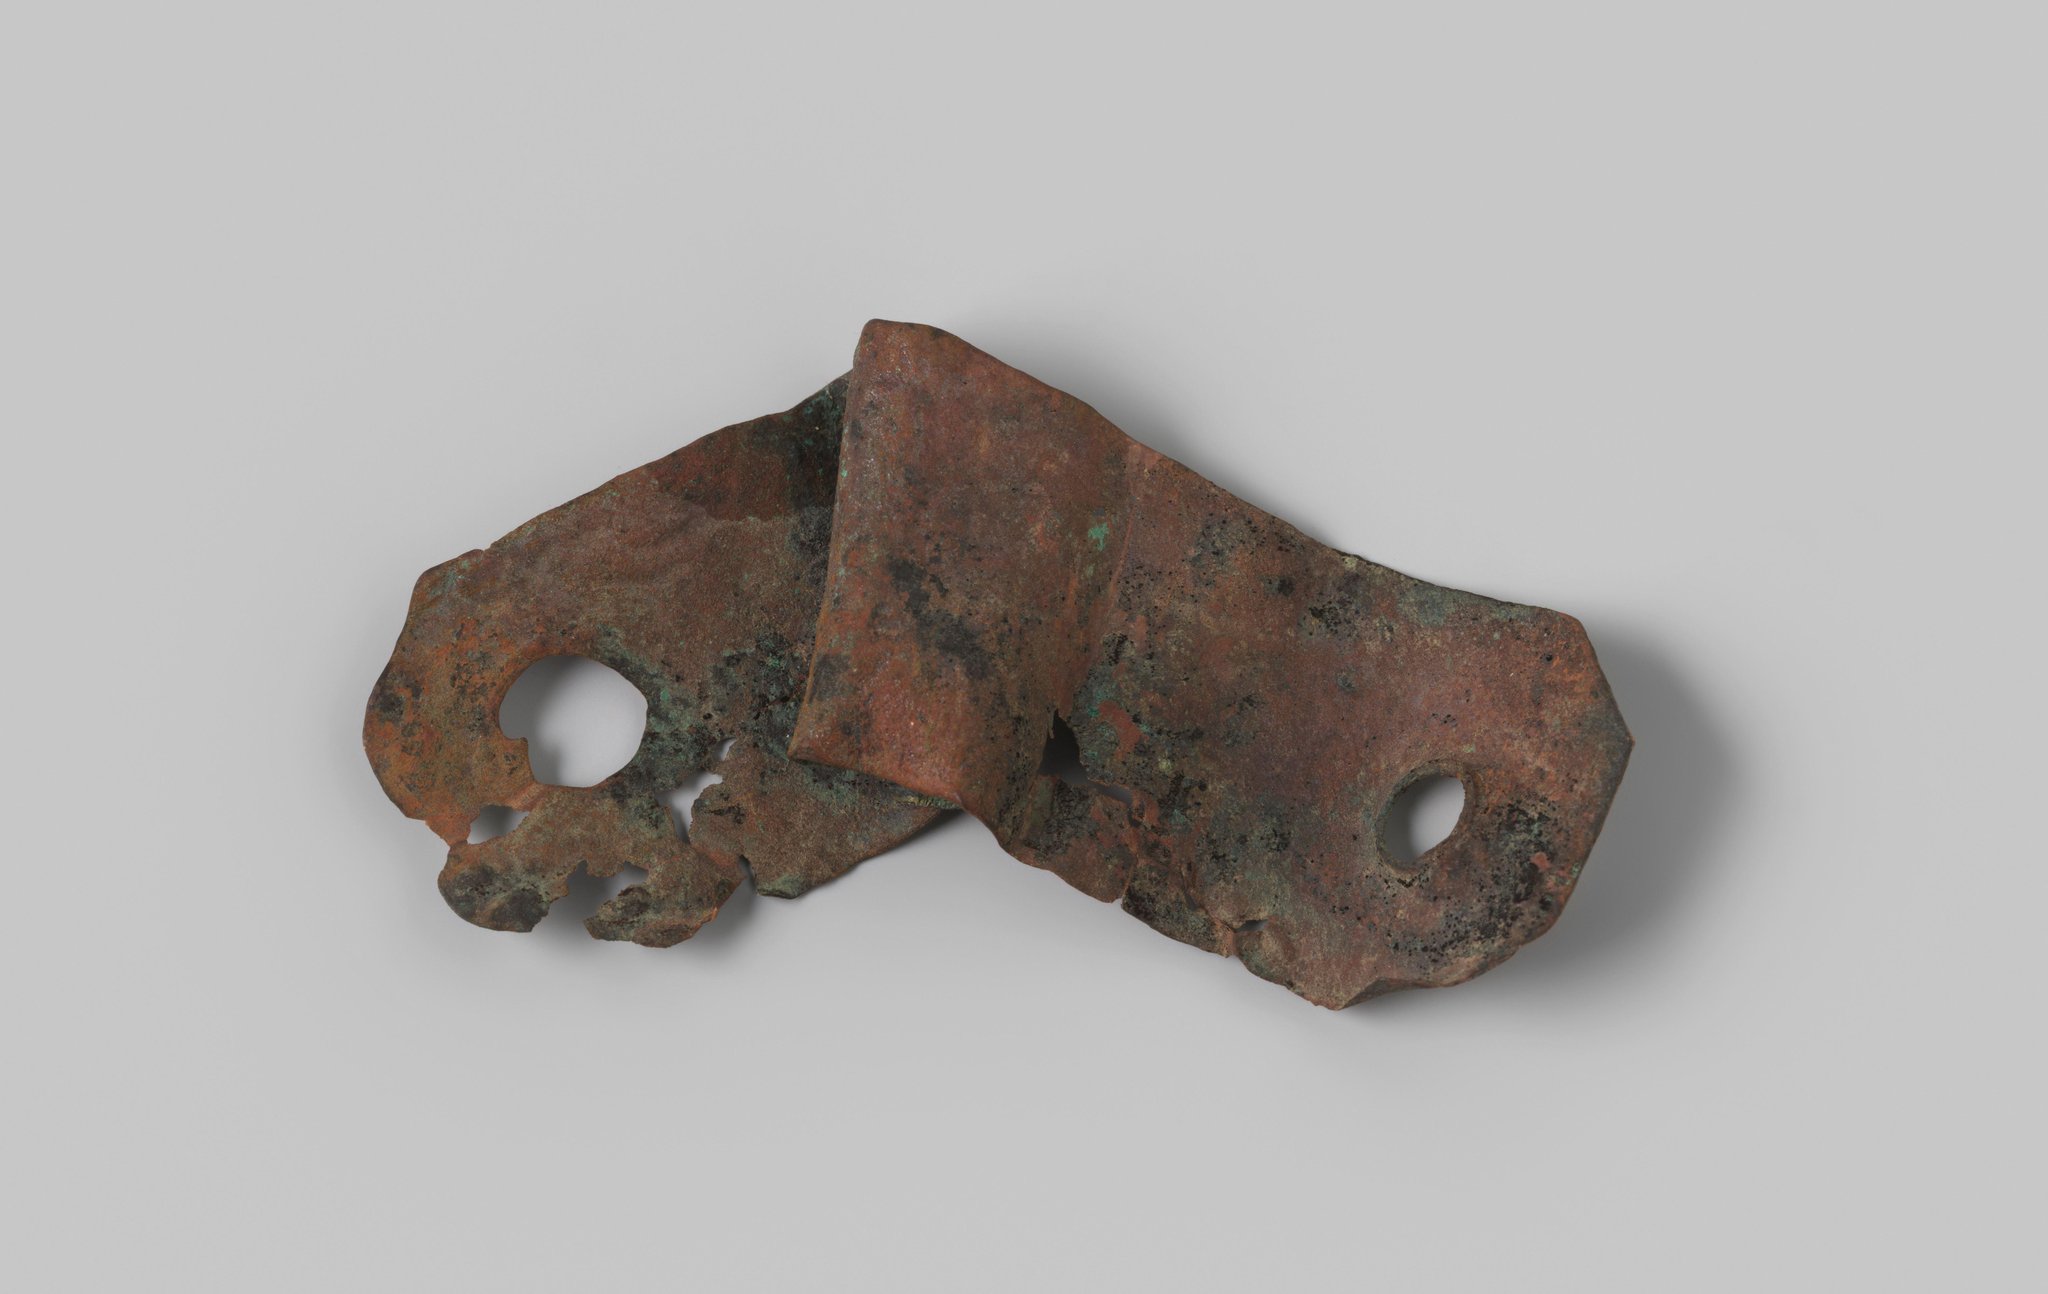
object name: lug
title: Oor van een kardoeskoker uit het wrak van de Oost-Indiëvaarder Hollandia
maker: Anonymous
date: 1700-1743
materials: copper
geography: netherlands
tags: verenigde oostindische compagnie, hollandia (schip), annet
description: Cartridge canister, lug; bent, eroded, id. NG 1980-27H2394.